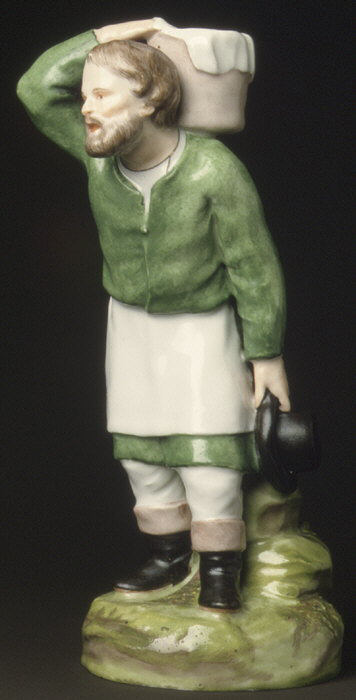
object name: figure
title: Ice Cream Seller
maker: imperial porcelain manufactory, st. petersburg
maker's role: manufactory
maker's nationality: russian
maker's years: 1744-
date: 1780-1800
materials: hard paste porcelain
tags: men,working